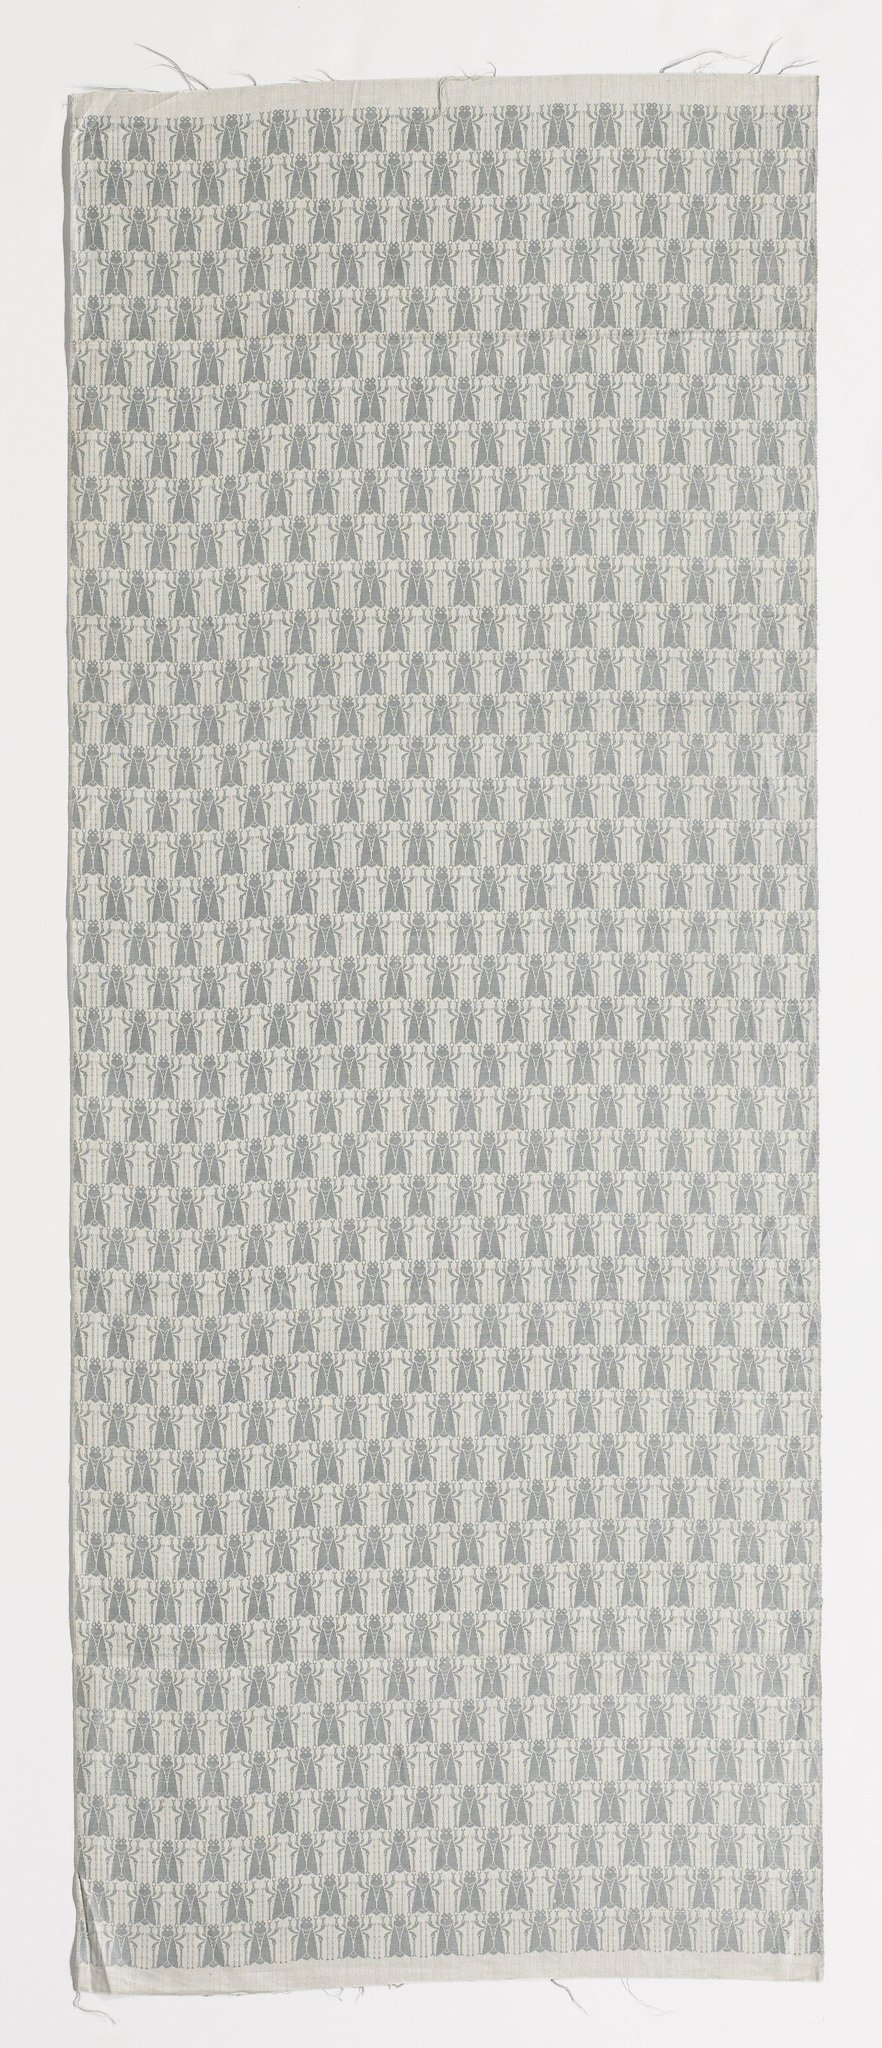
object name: upholstered wall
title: Wandbespanning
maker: chris lebeau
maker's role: draughtsman, print maker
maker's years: 1878-1945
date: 1911-1915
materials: linen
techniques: damask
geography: eindhoven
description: Grijs damasten wandbespanning met een dessin van bijen.